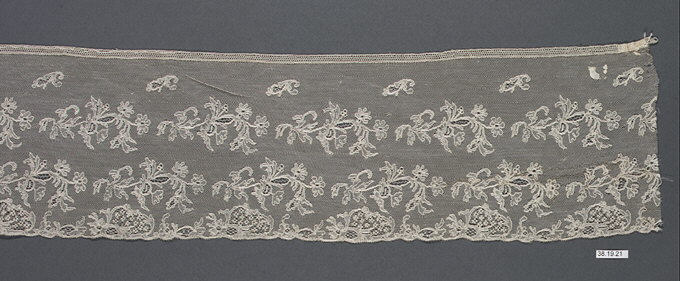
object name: flounce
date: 1701-1800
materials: lace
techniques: lace